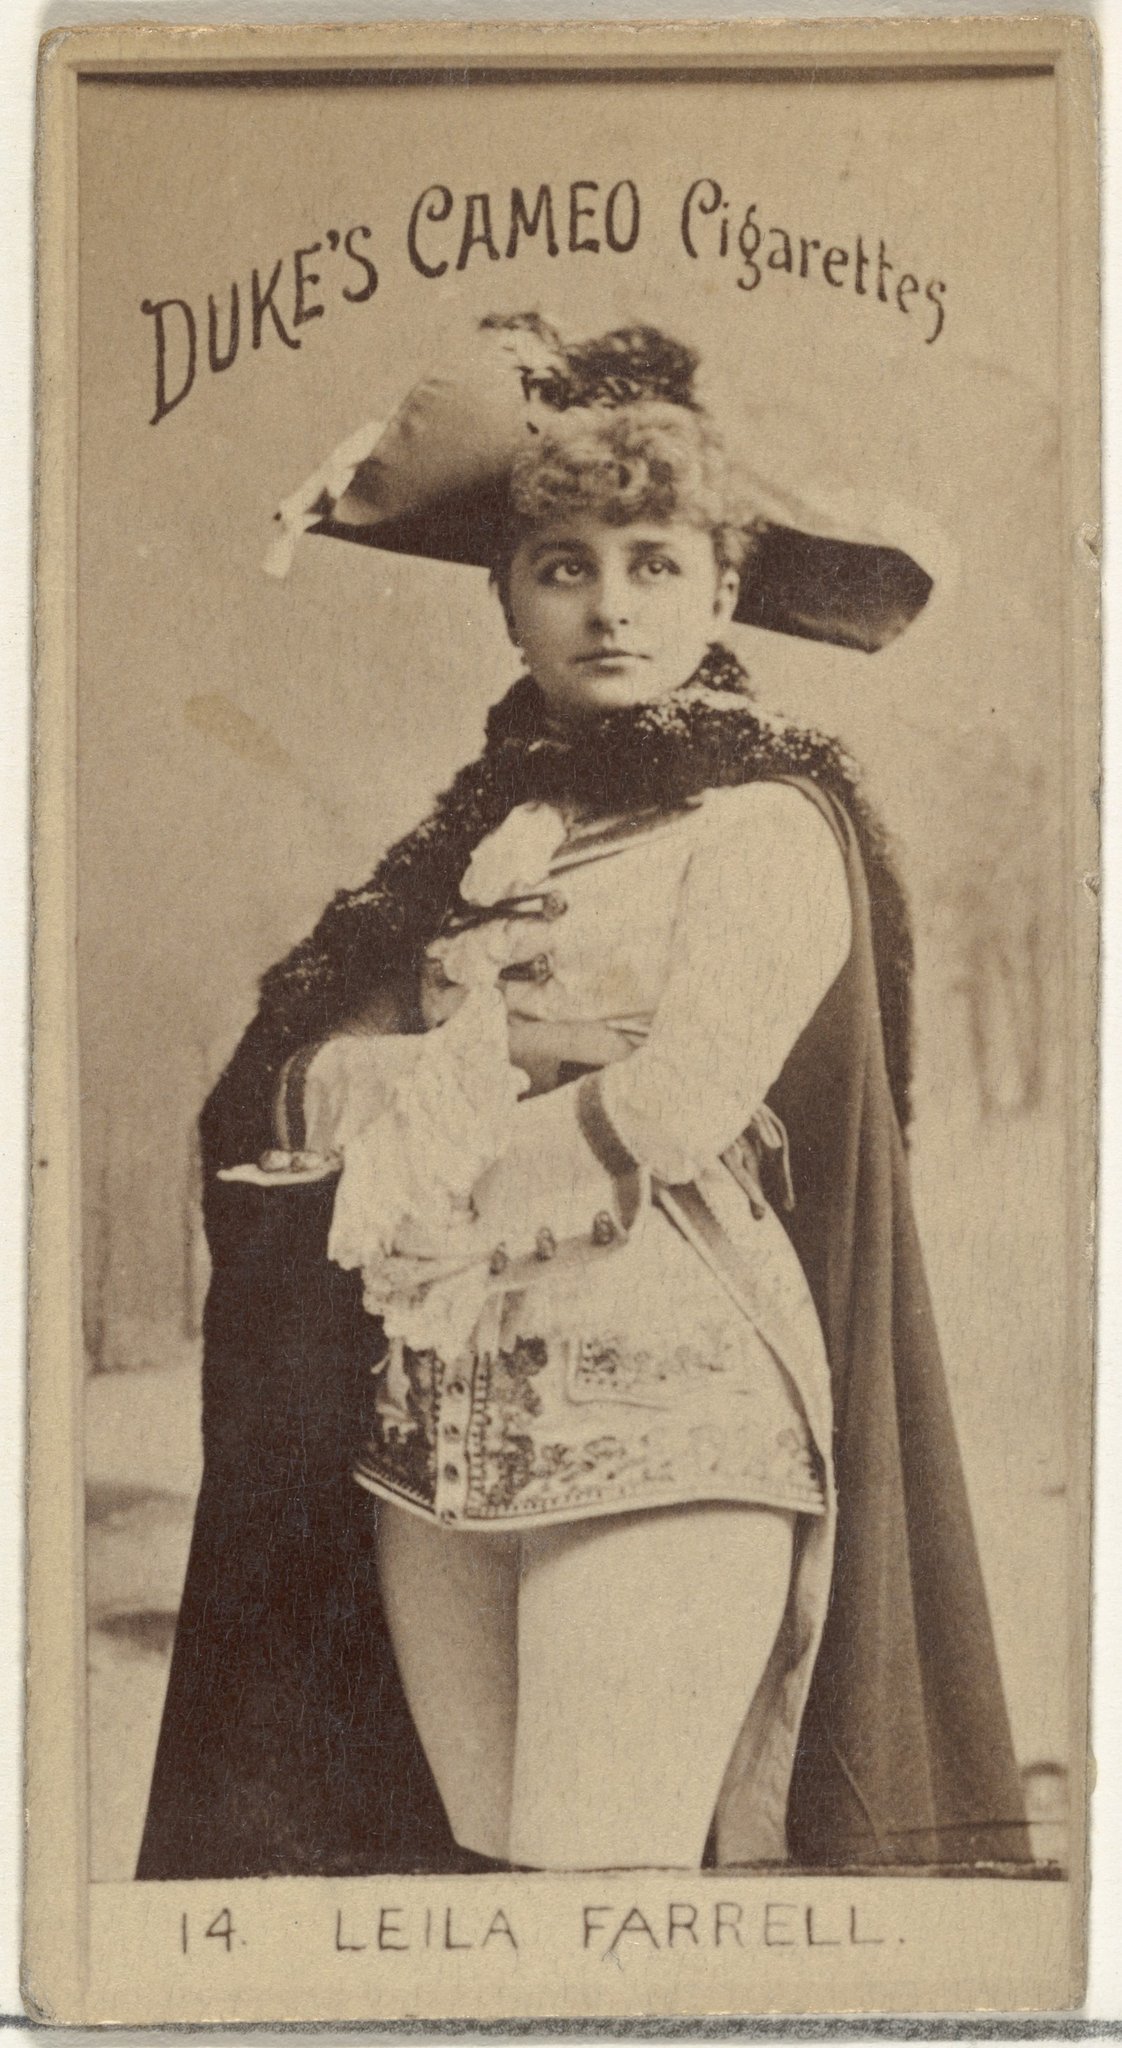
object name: photograph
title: Card Number 14, Leila Farrell, from the Actors and Actresses series (N145-4) issued by Duke Sons & Co. to promote Cameo Cigarettes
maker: w. duke, sons & co.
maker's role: publisher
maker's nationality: american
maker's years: 1870-1920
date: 1880-1889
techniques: albumen silver print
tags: portraits,women,actresses